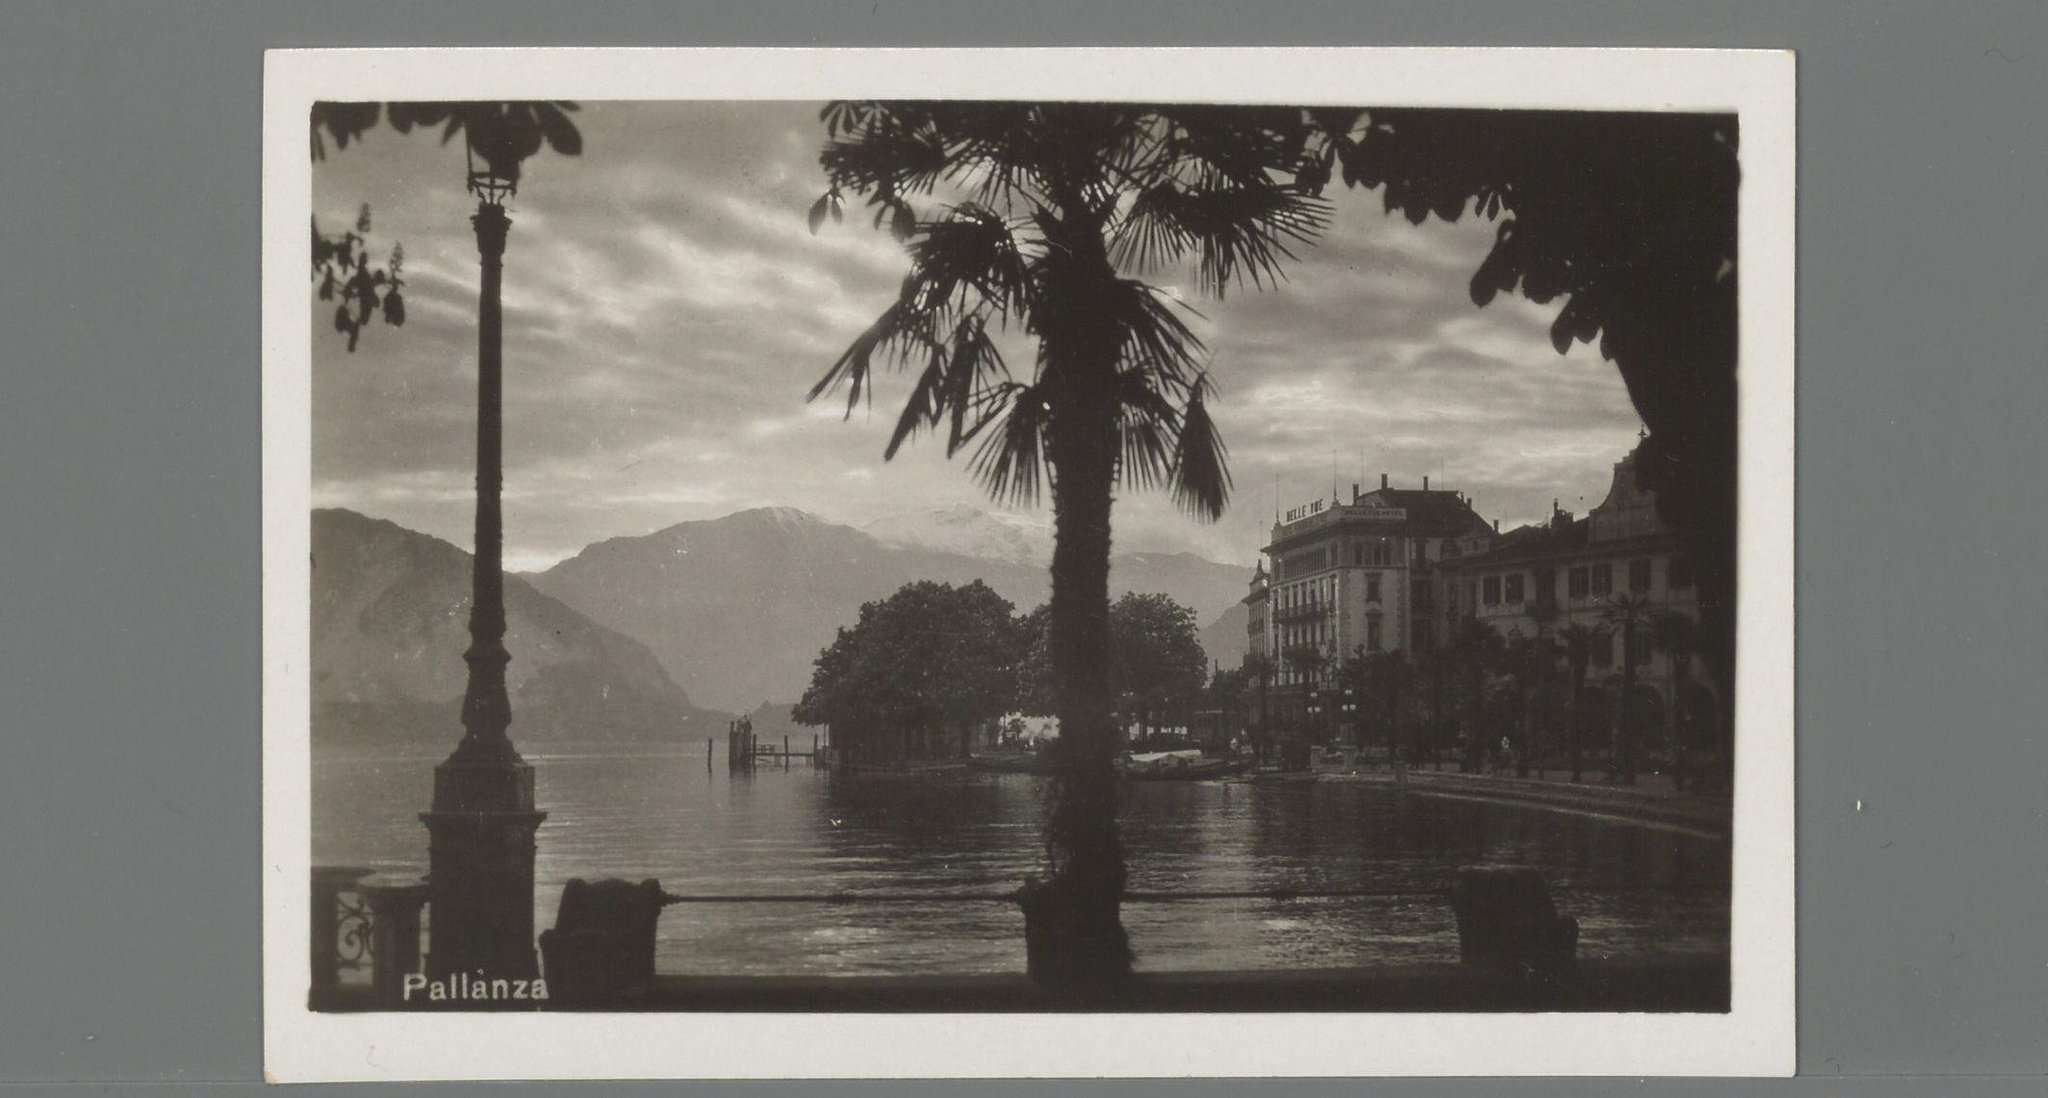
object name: photograph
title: Pallanza ed Isole Borromee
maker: Anonymous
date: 1904-1935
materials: photographic support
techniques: photography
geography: pallanza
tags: city-view, and landscape with man-made constructions, lake, trees: palm-tree